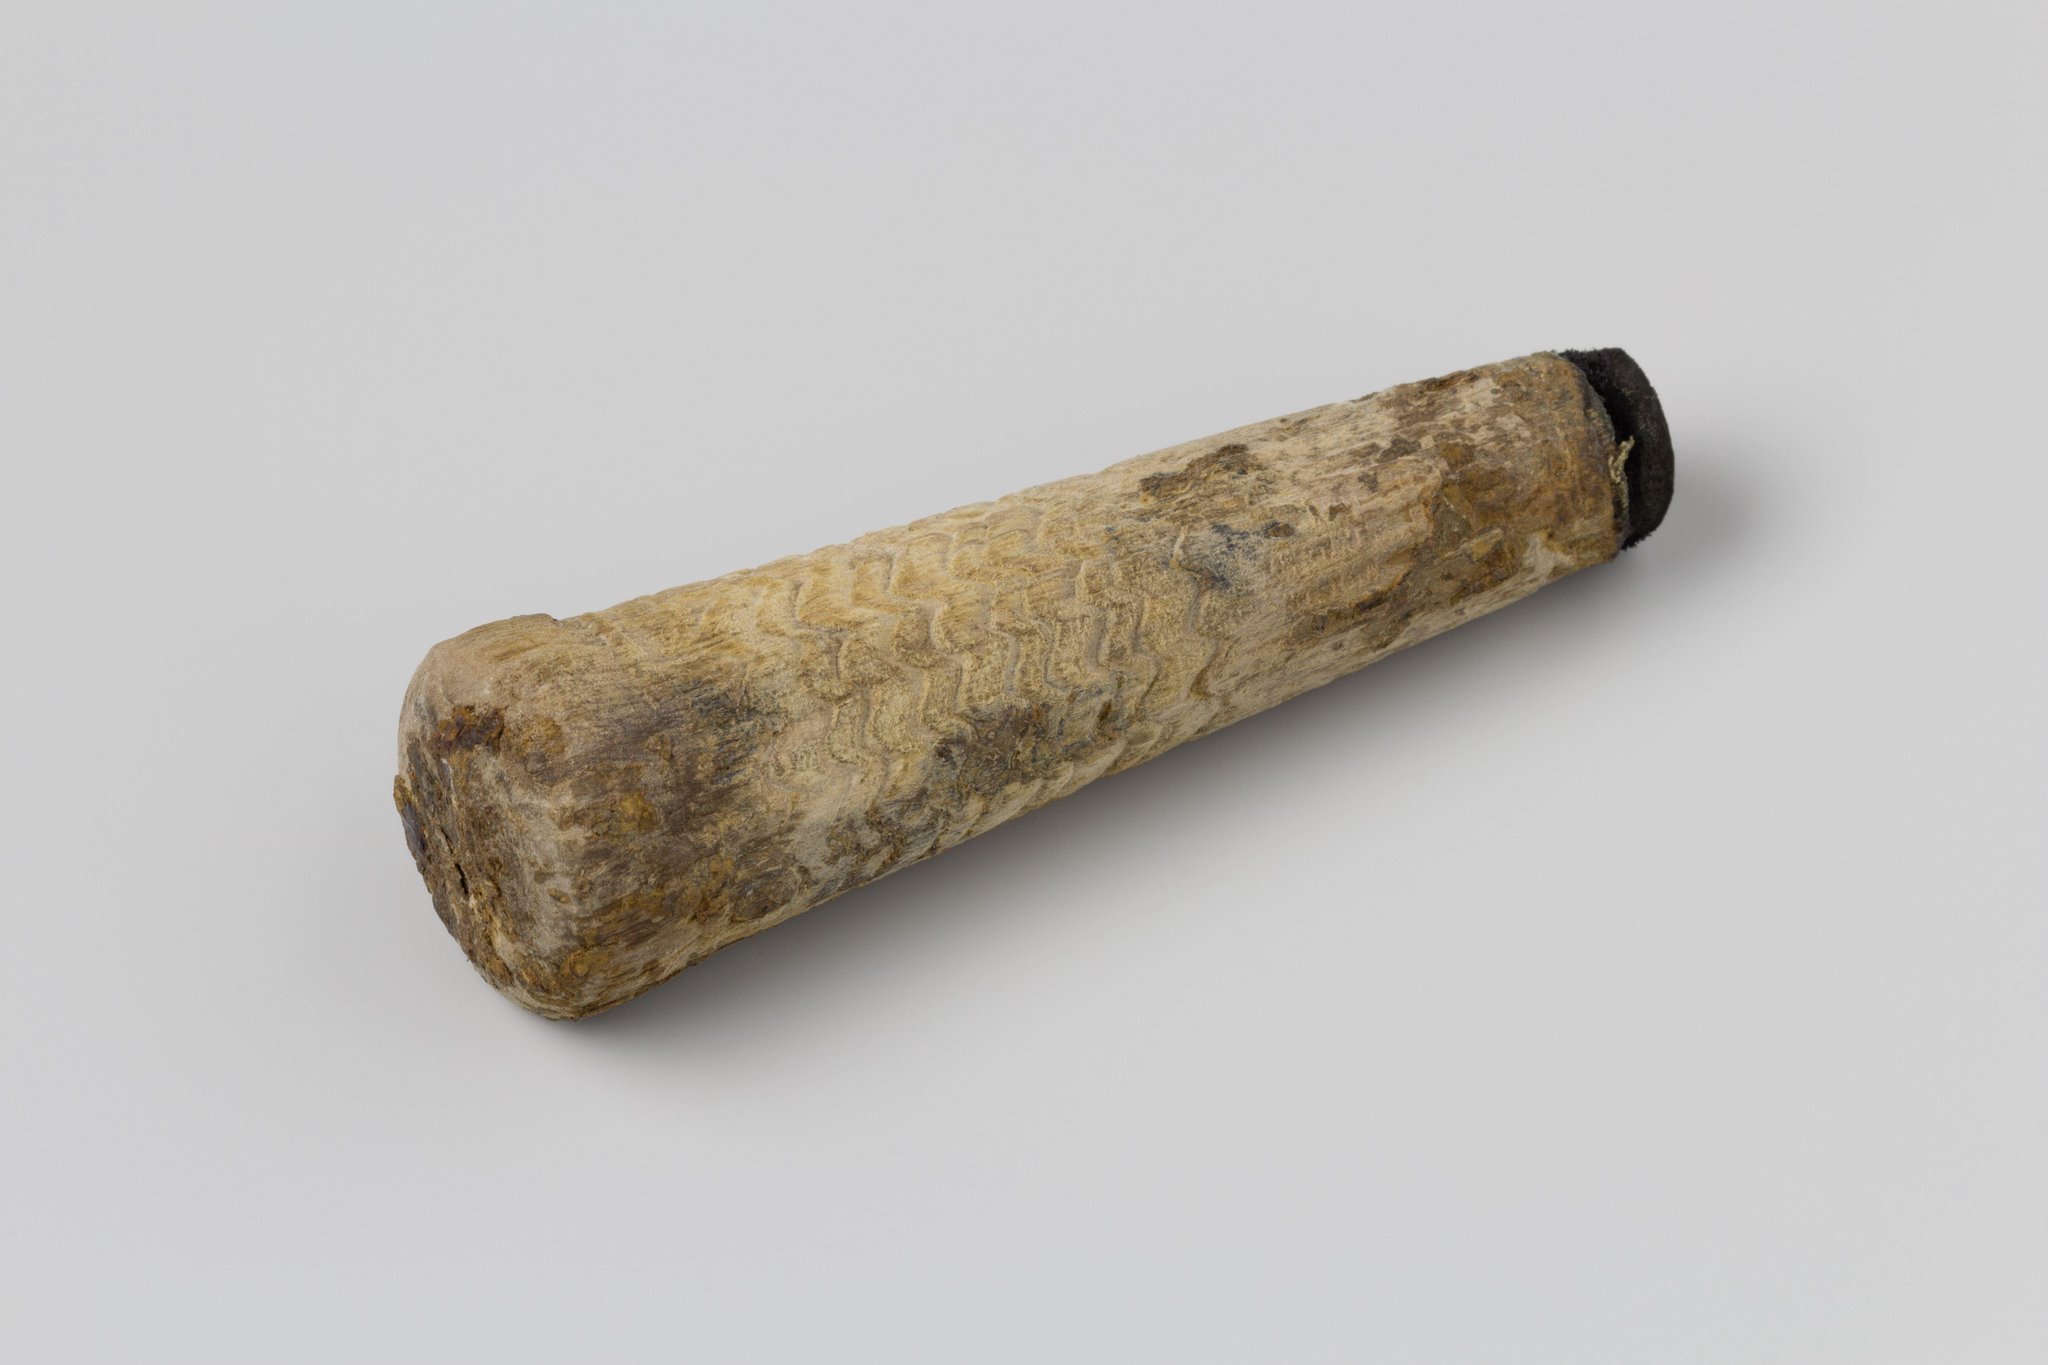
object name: knife handle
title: Messenheft uit het wrak van de Oost-Indiëvaarder Hollandia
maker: Anonymous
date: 1700-1743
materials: copper, wood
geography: netherlands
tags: verenigde oostindische compagnie, hollandia (schip), annet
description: Knife, handle, cylindrical: tapering; id. NG 1979-403H, ferrule, id. NG 1980-27H426.